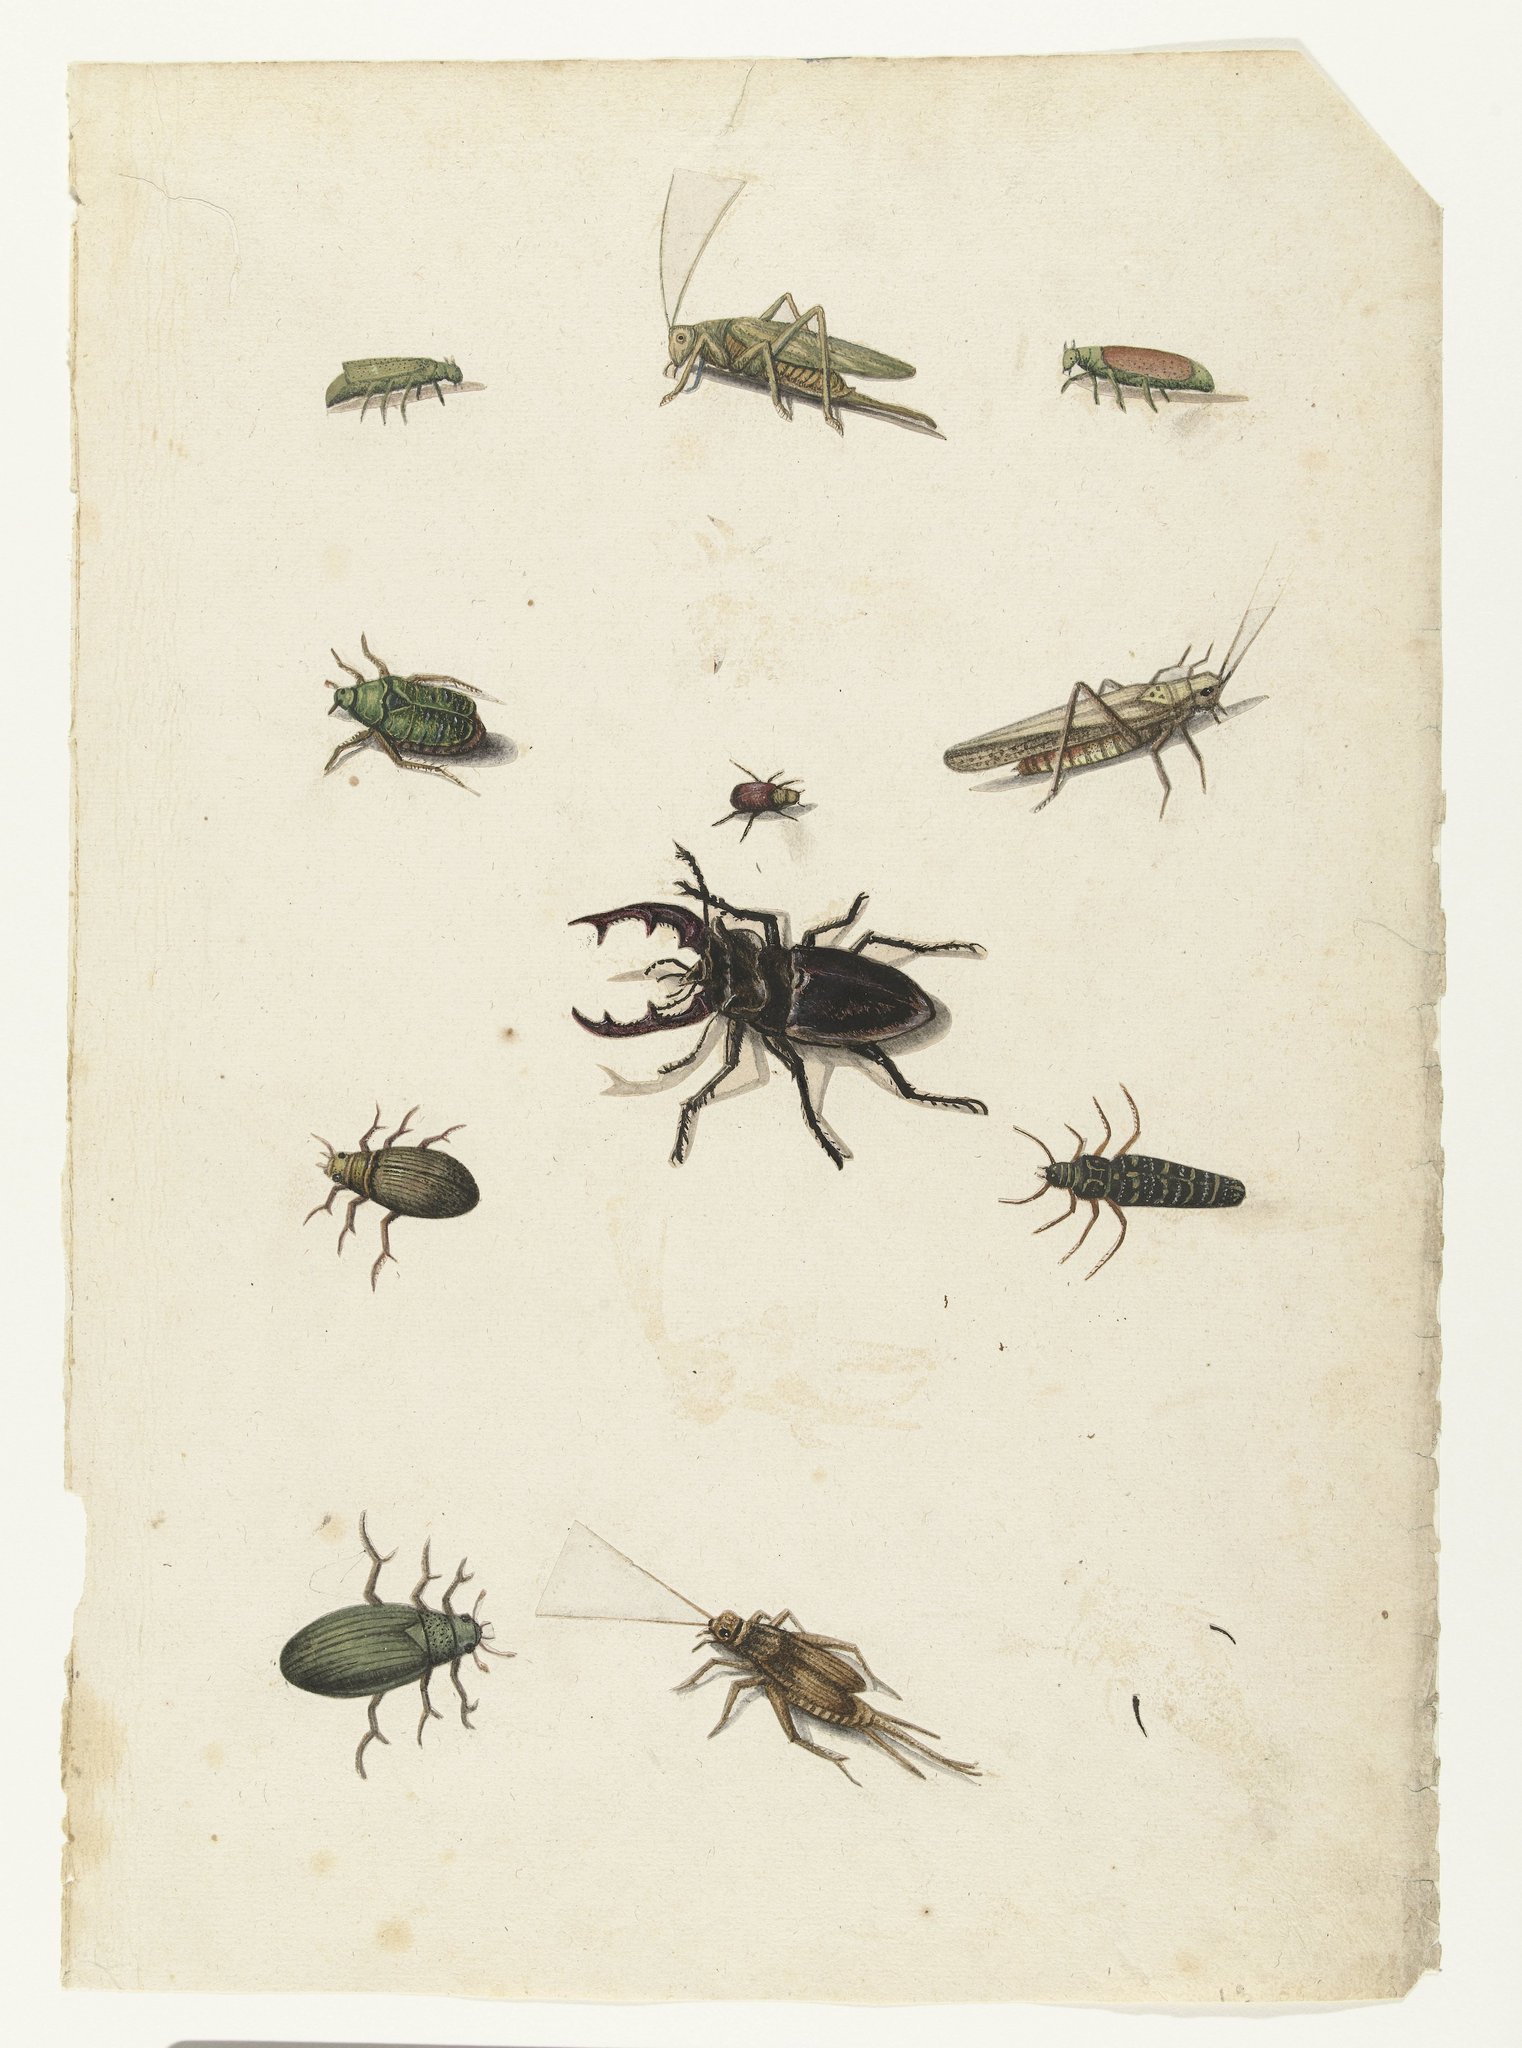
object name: drawing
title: Vliegend hert, twee sprinkhanen en acht kevers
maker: Anonymous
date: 1560-1585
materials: paper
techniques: brush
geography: low countries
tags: insects: stag-beetle, insects: grass-hopper, insects: beetle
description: Blad uit album van 100 (?) bladen met tekeningen van dieren.